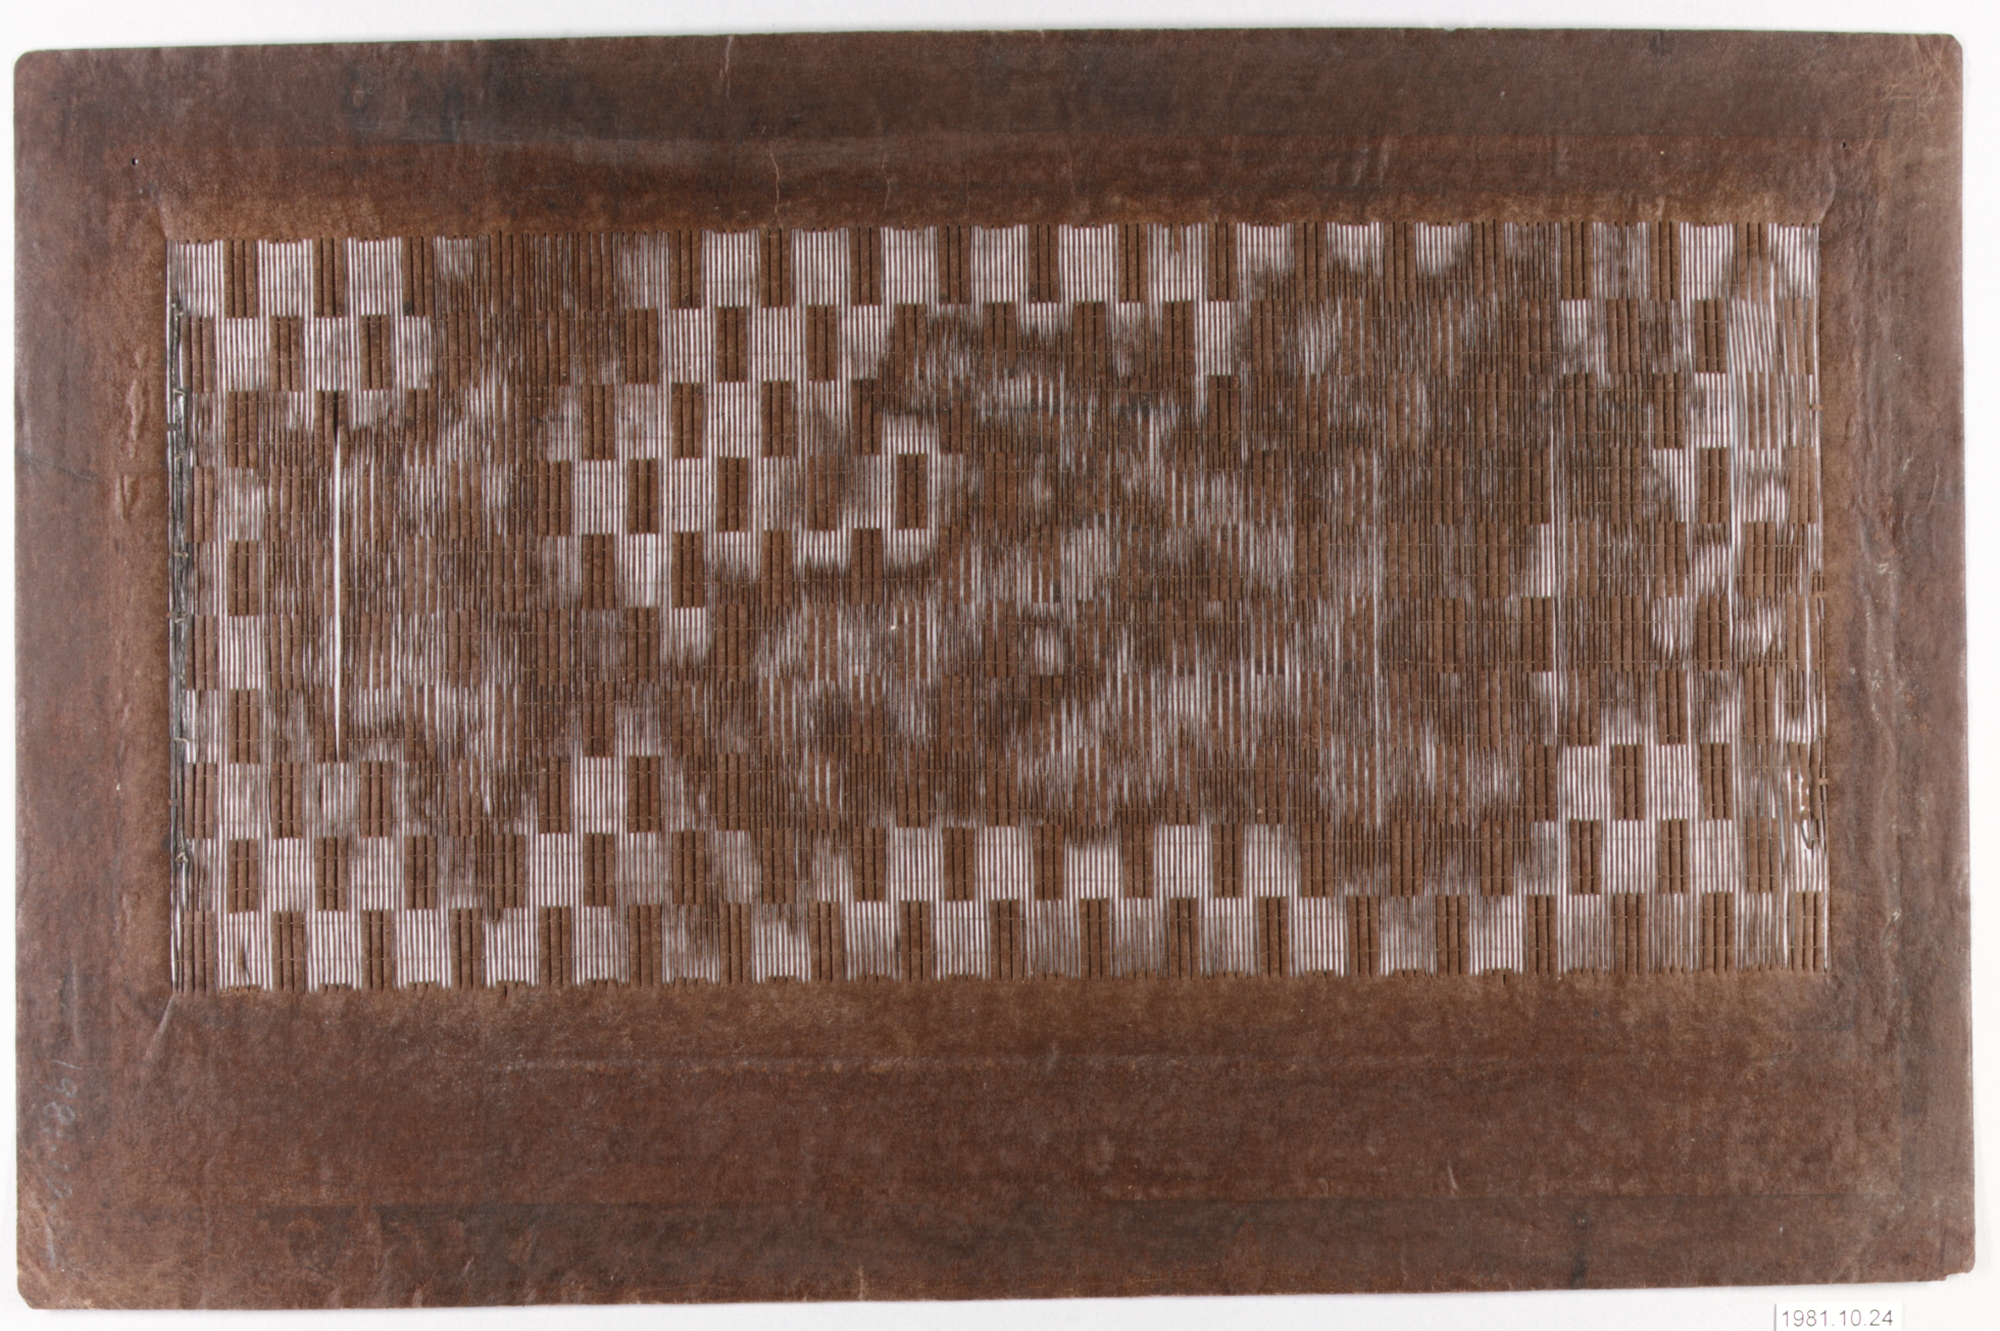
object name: stencil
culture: japanese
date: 1801-1900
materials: paper